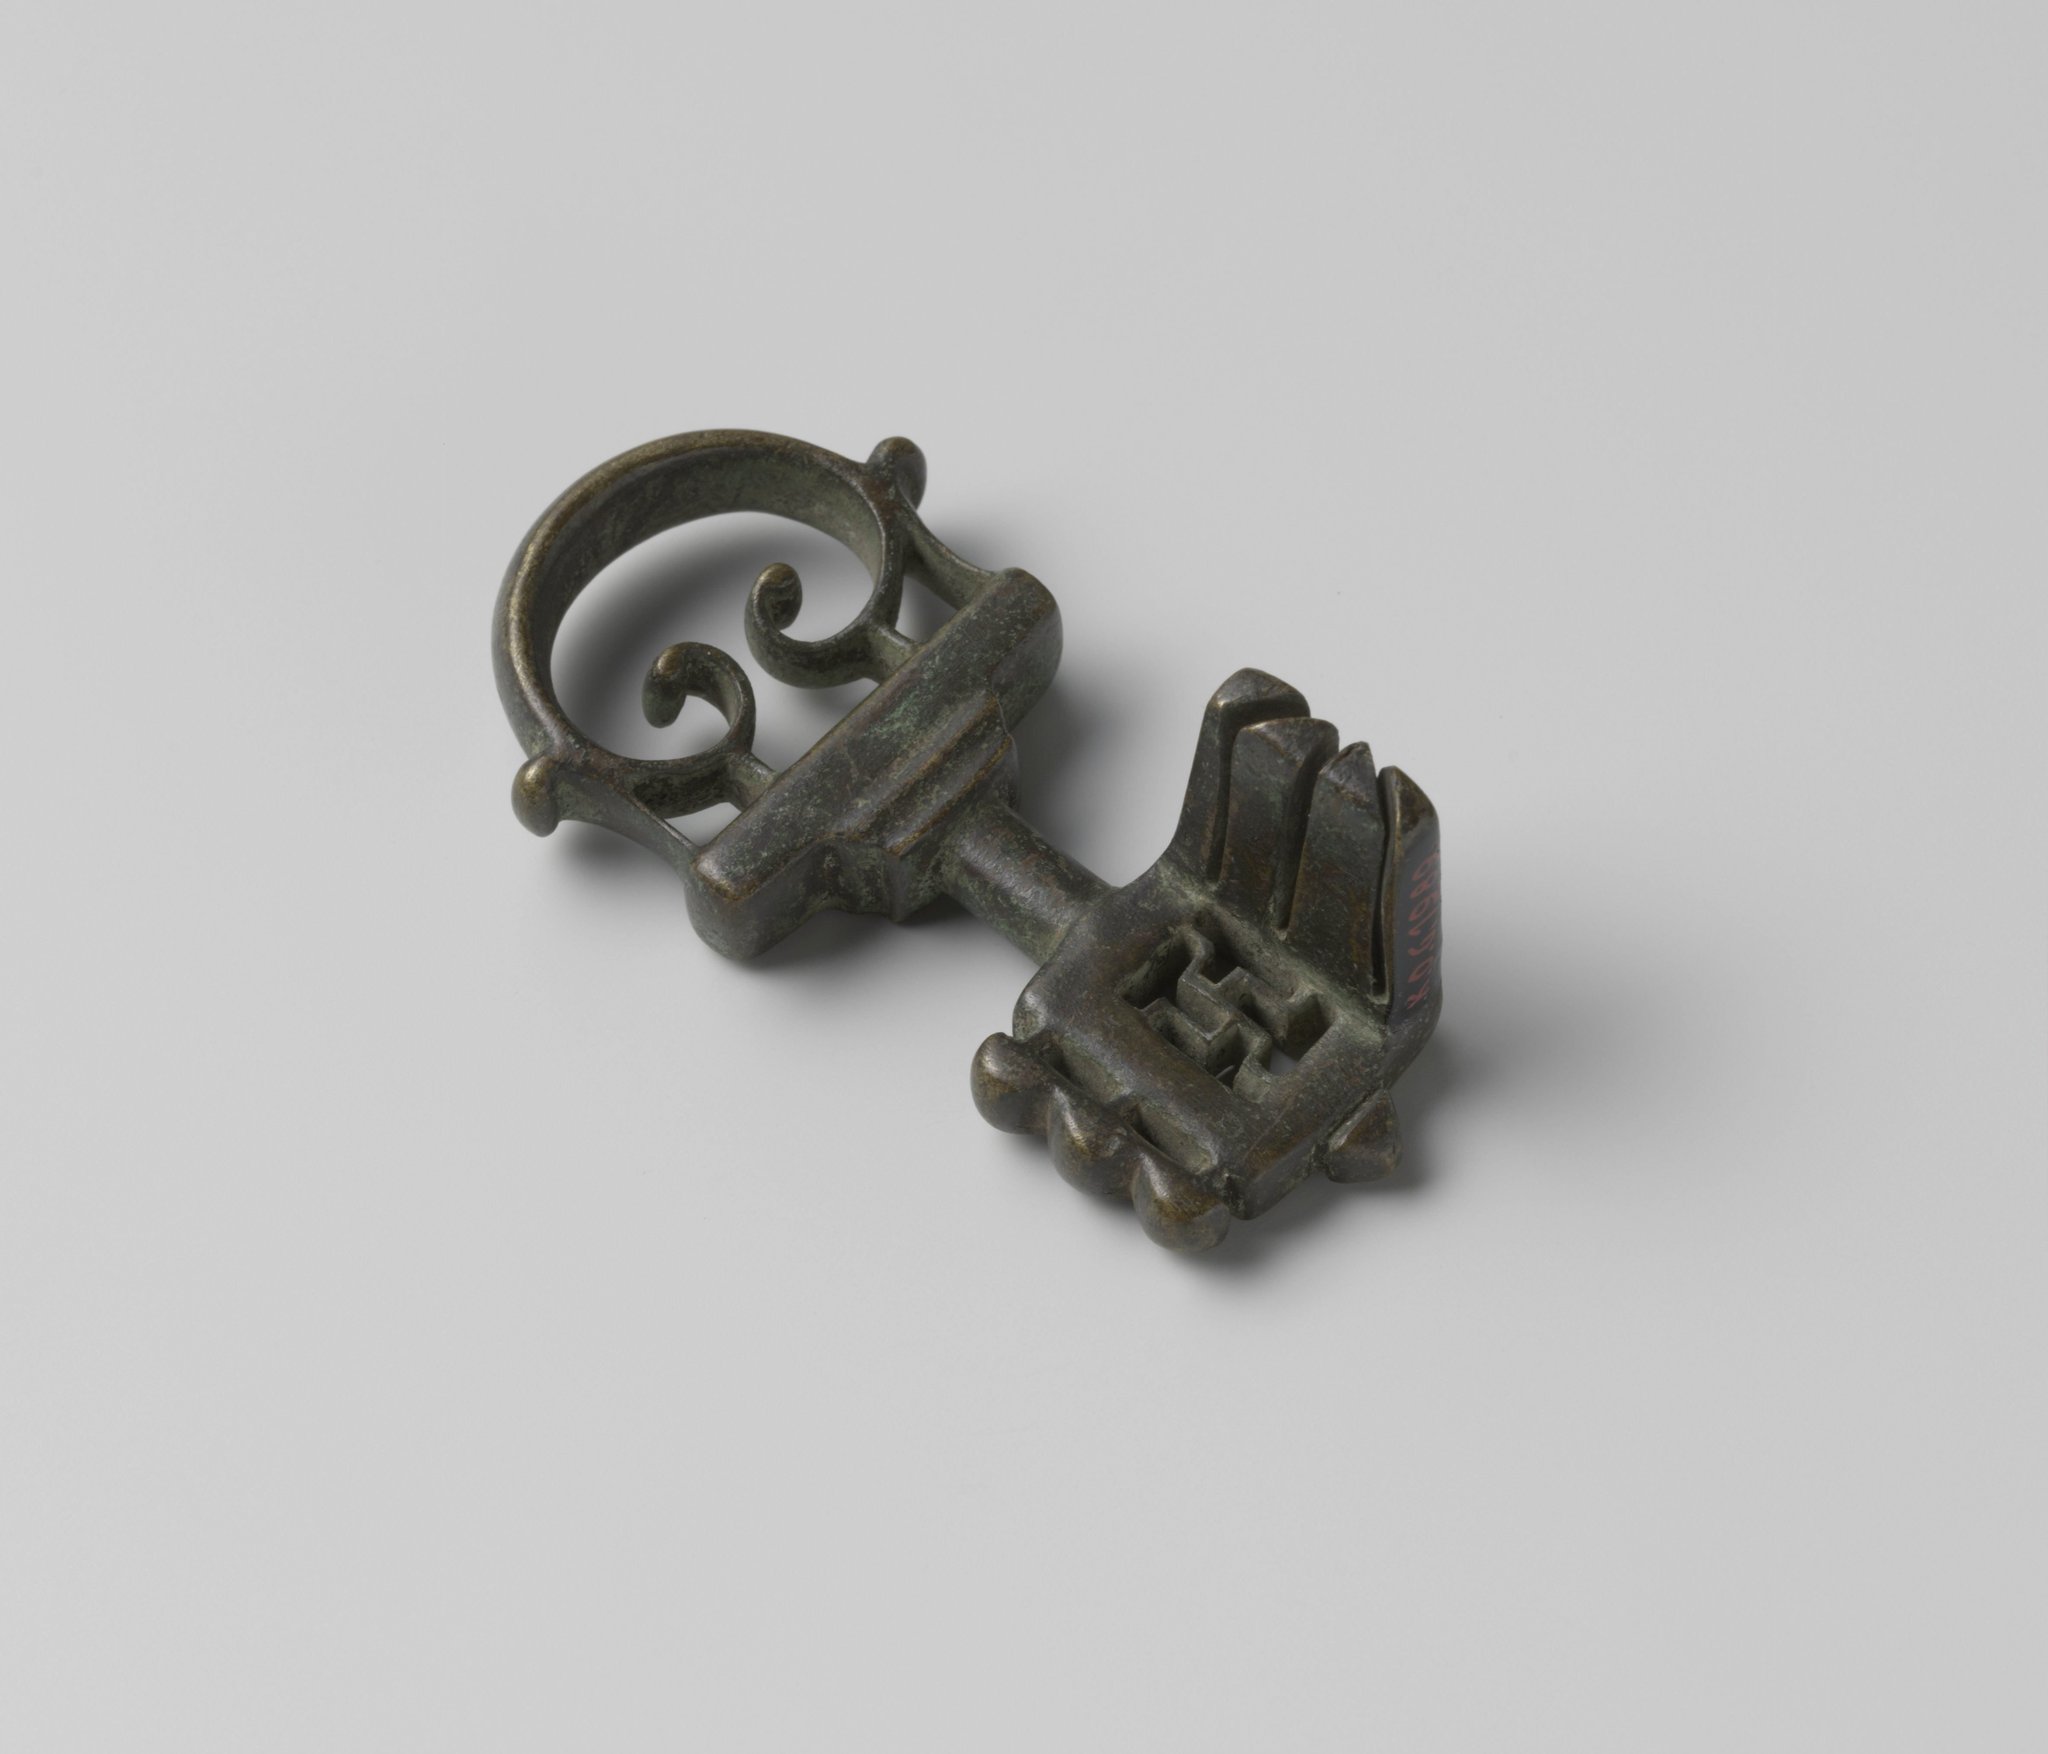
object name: key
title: Sleutel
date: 1400-1950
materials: bronze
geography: rome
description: Sleutel met een greep gevormd door een naar beneden gewende C-voluten door vier staafjes met de sleutelbord verbonden. De baard is versierd met het zonneteken.